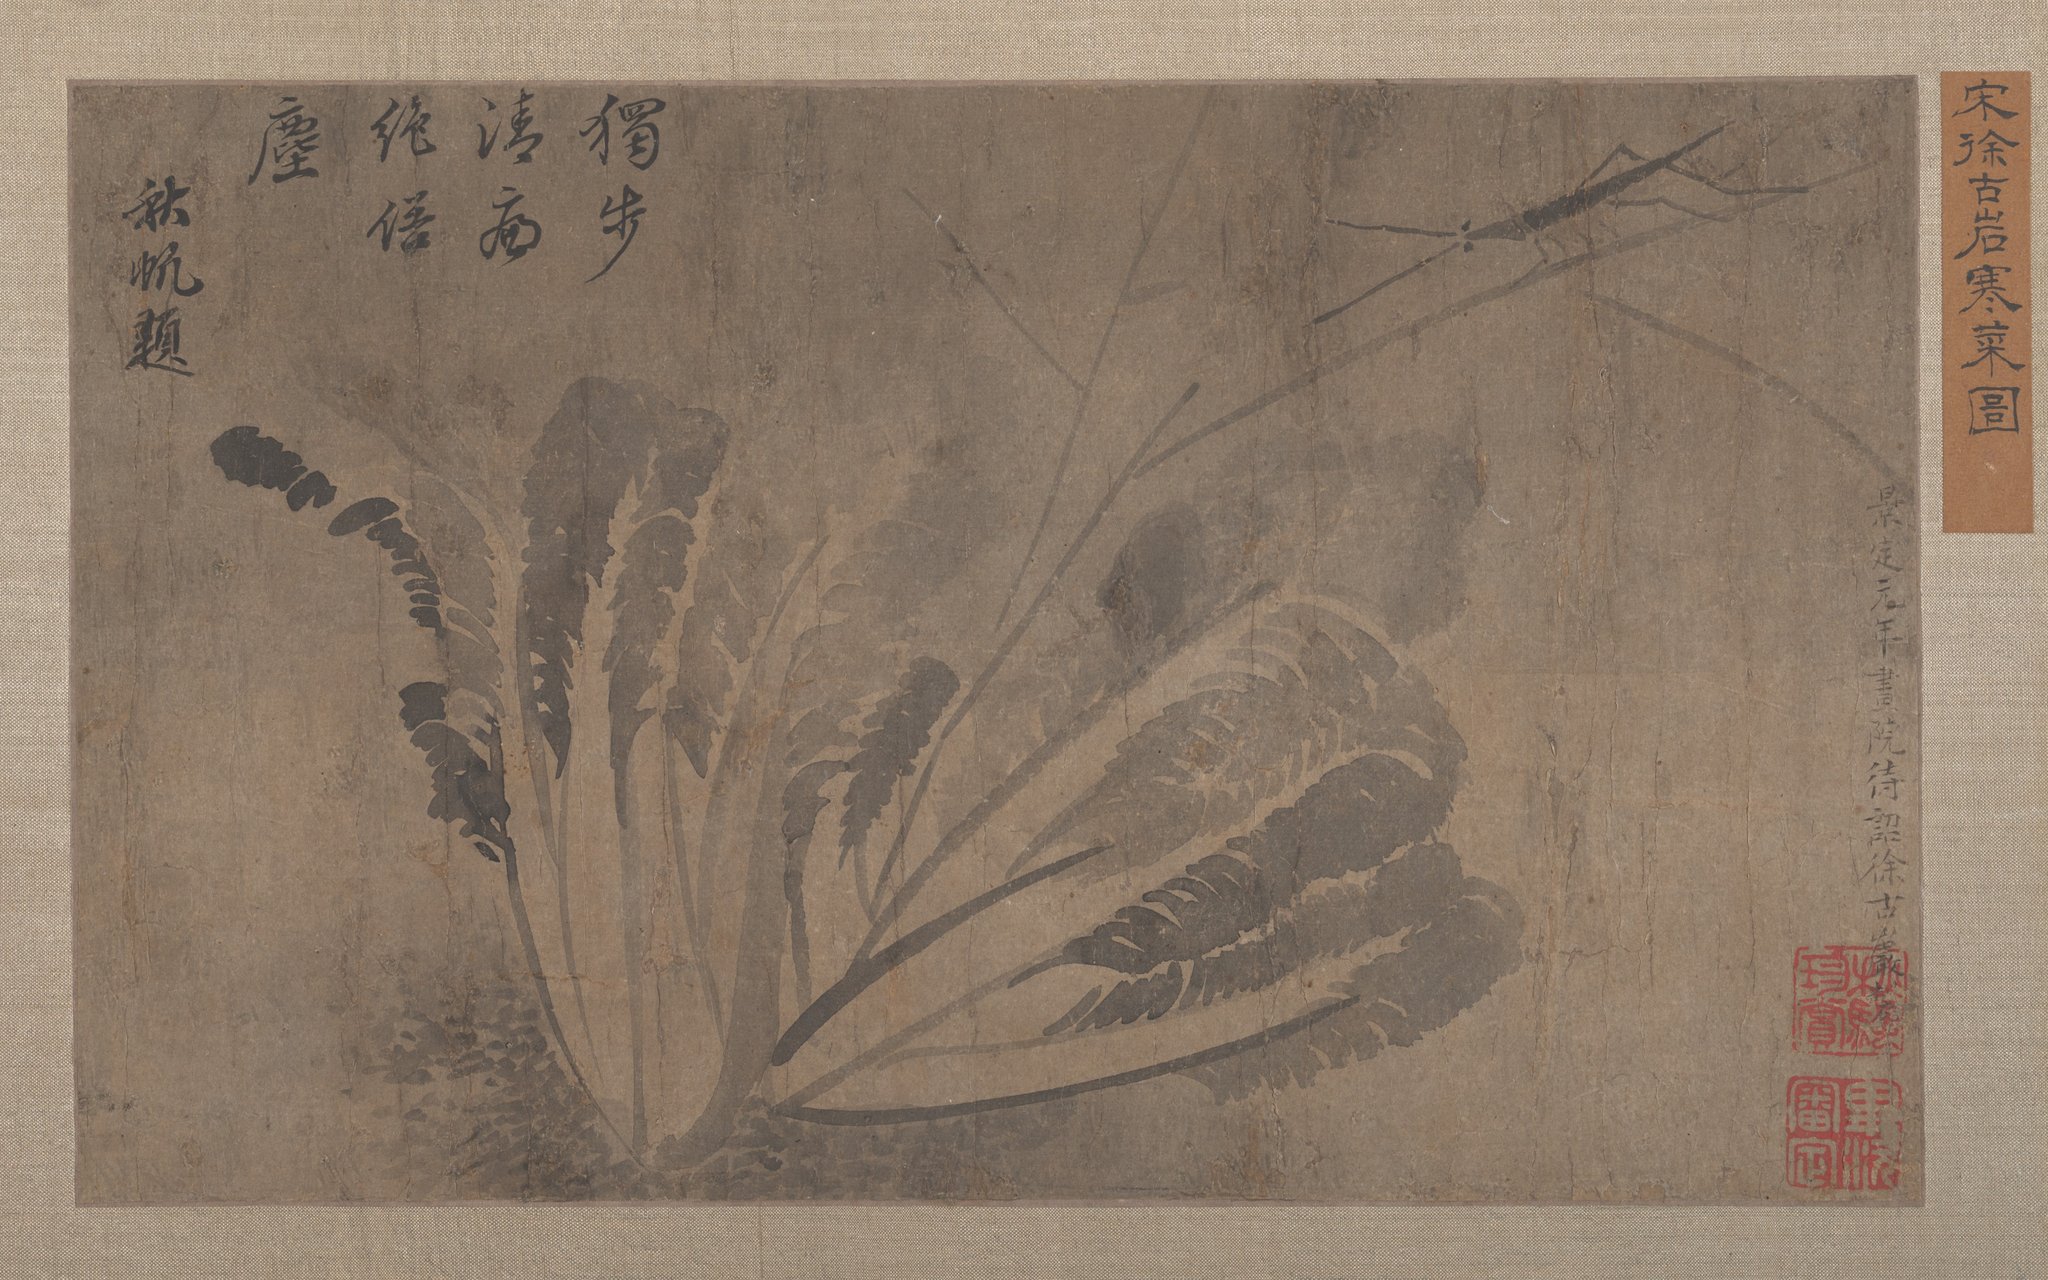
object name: album leaf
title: Cabbage and Insects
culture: chinese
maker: xü daoguang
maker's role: artist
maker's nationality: chinese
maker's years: 1200-1299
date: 1200-1299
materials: paper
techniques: wash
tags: vegetables,insects